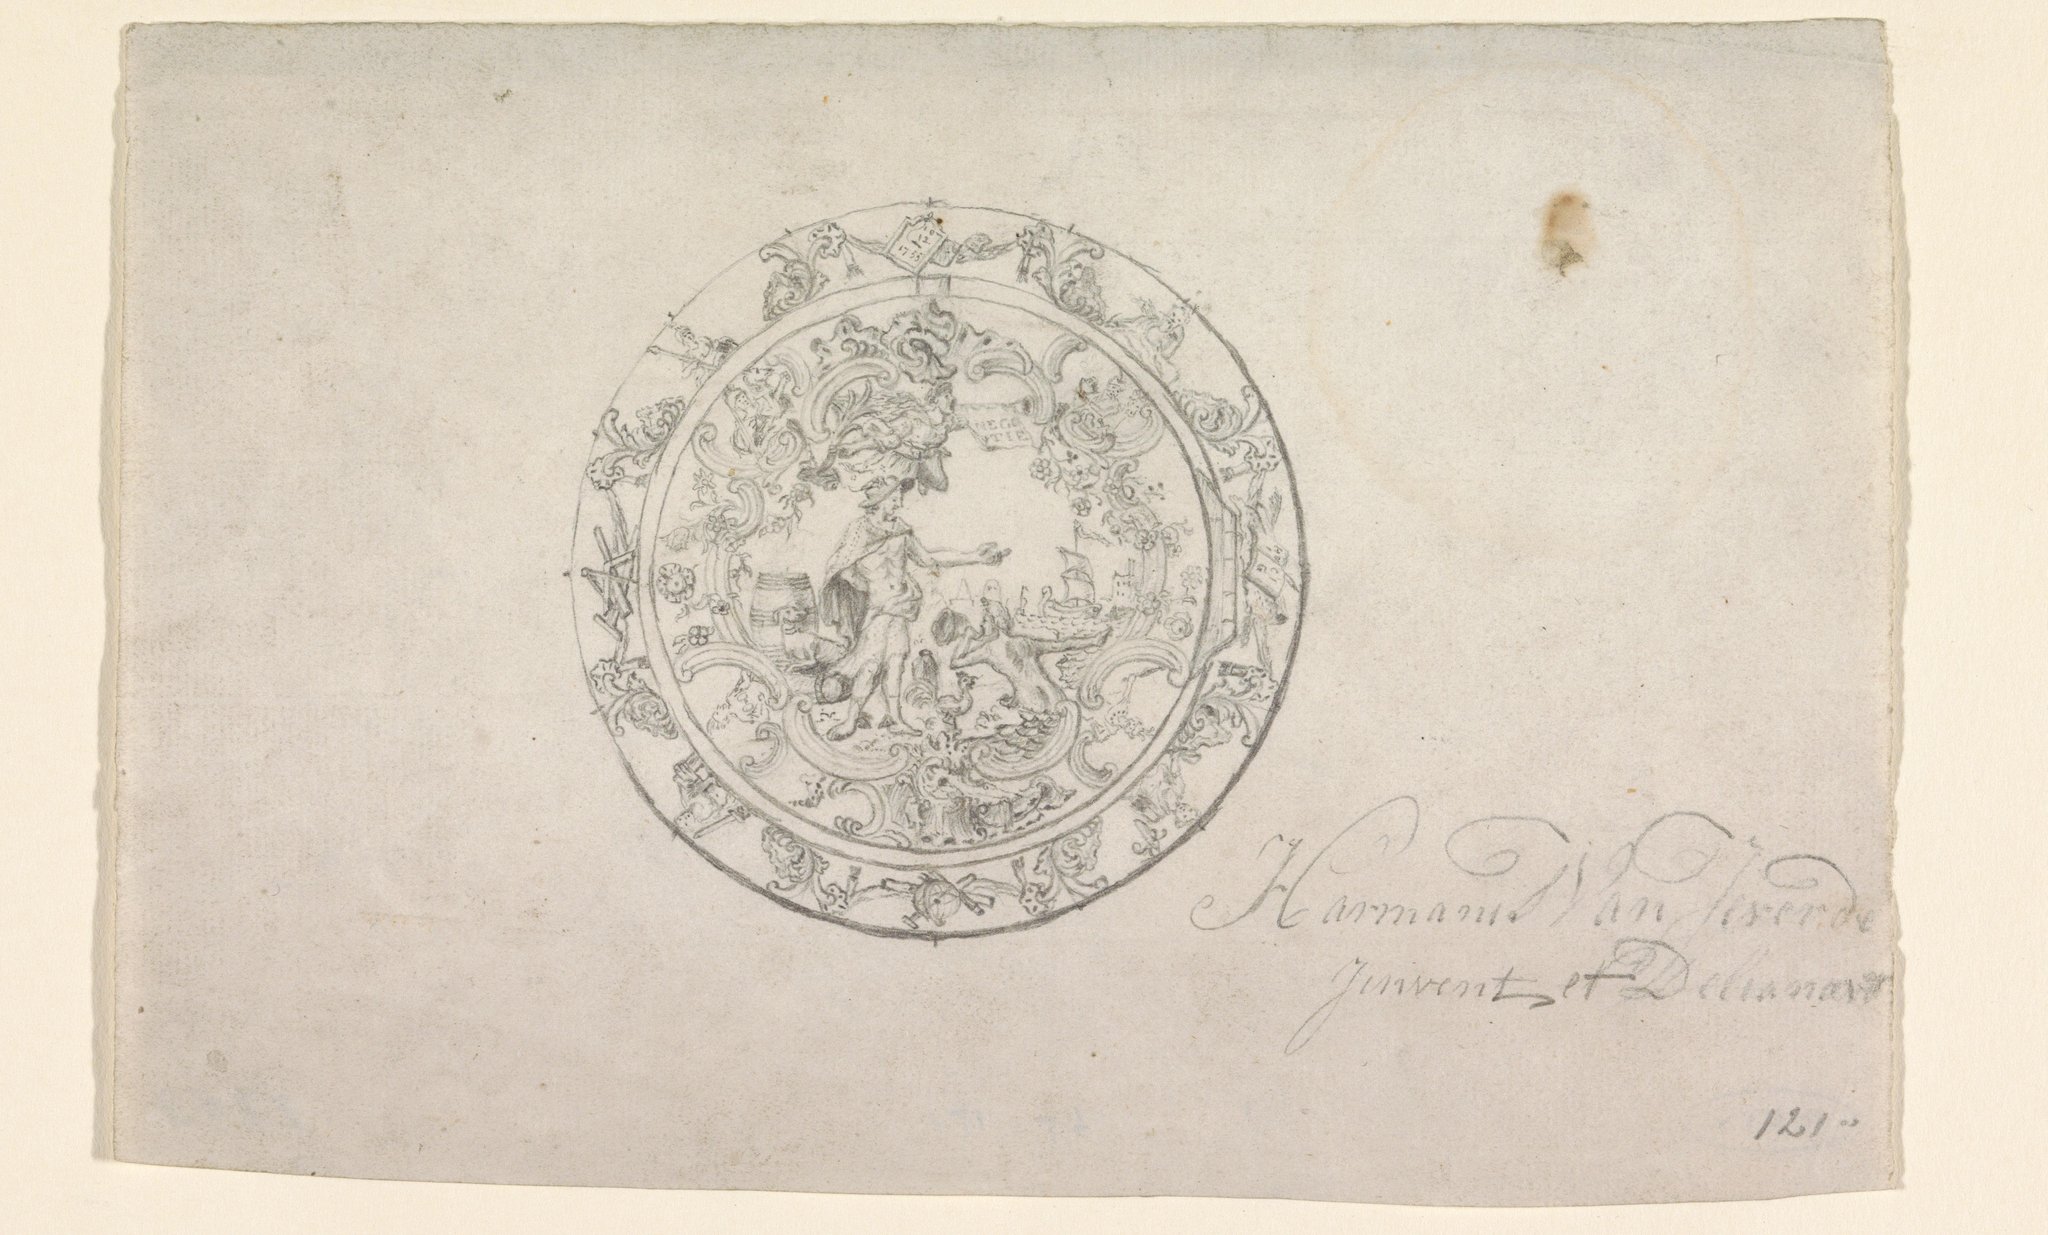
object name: drawing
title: Handel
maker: hermanus van jeverde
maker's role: draughtsman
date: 1755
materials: paper, pencil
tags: allegory of trade; 'commertio della vita humana' (ripa)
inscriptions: collector's mark: Lugt 2228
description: Ontwerp voor een tabaksdoos of schotel met allegorie van de handel. In een ronde omlijsting met rocailles, goden en diverse attributen behorend bij kunsten staat Mercurius in een landschap. Links en rechts van Mercurius een ton, hond en een haan. Rechts blaast een figuur in het water op een hoorn, in de achtergrond varen schepen. Boven Mercurius vliegt een engel met een vaandel met tekst Negotie.